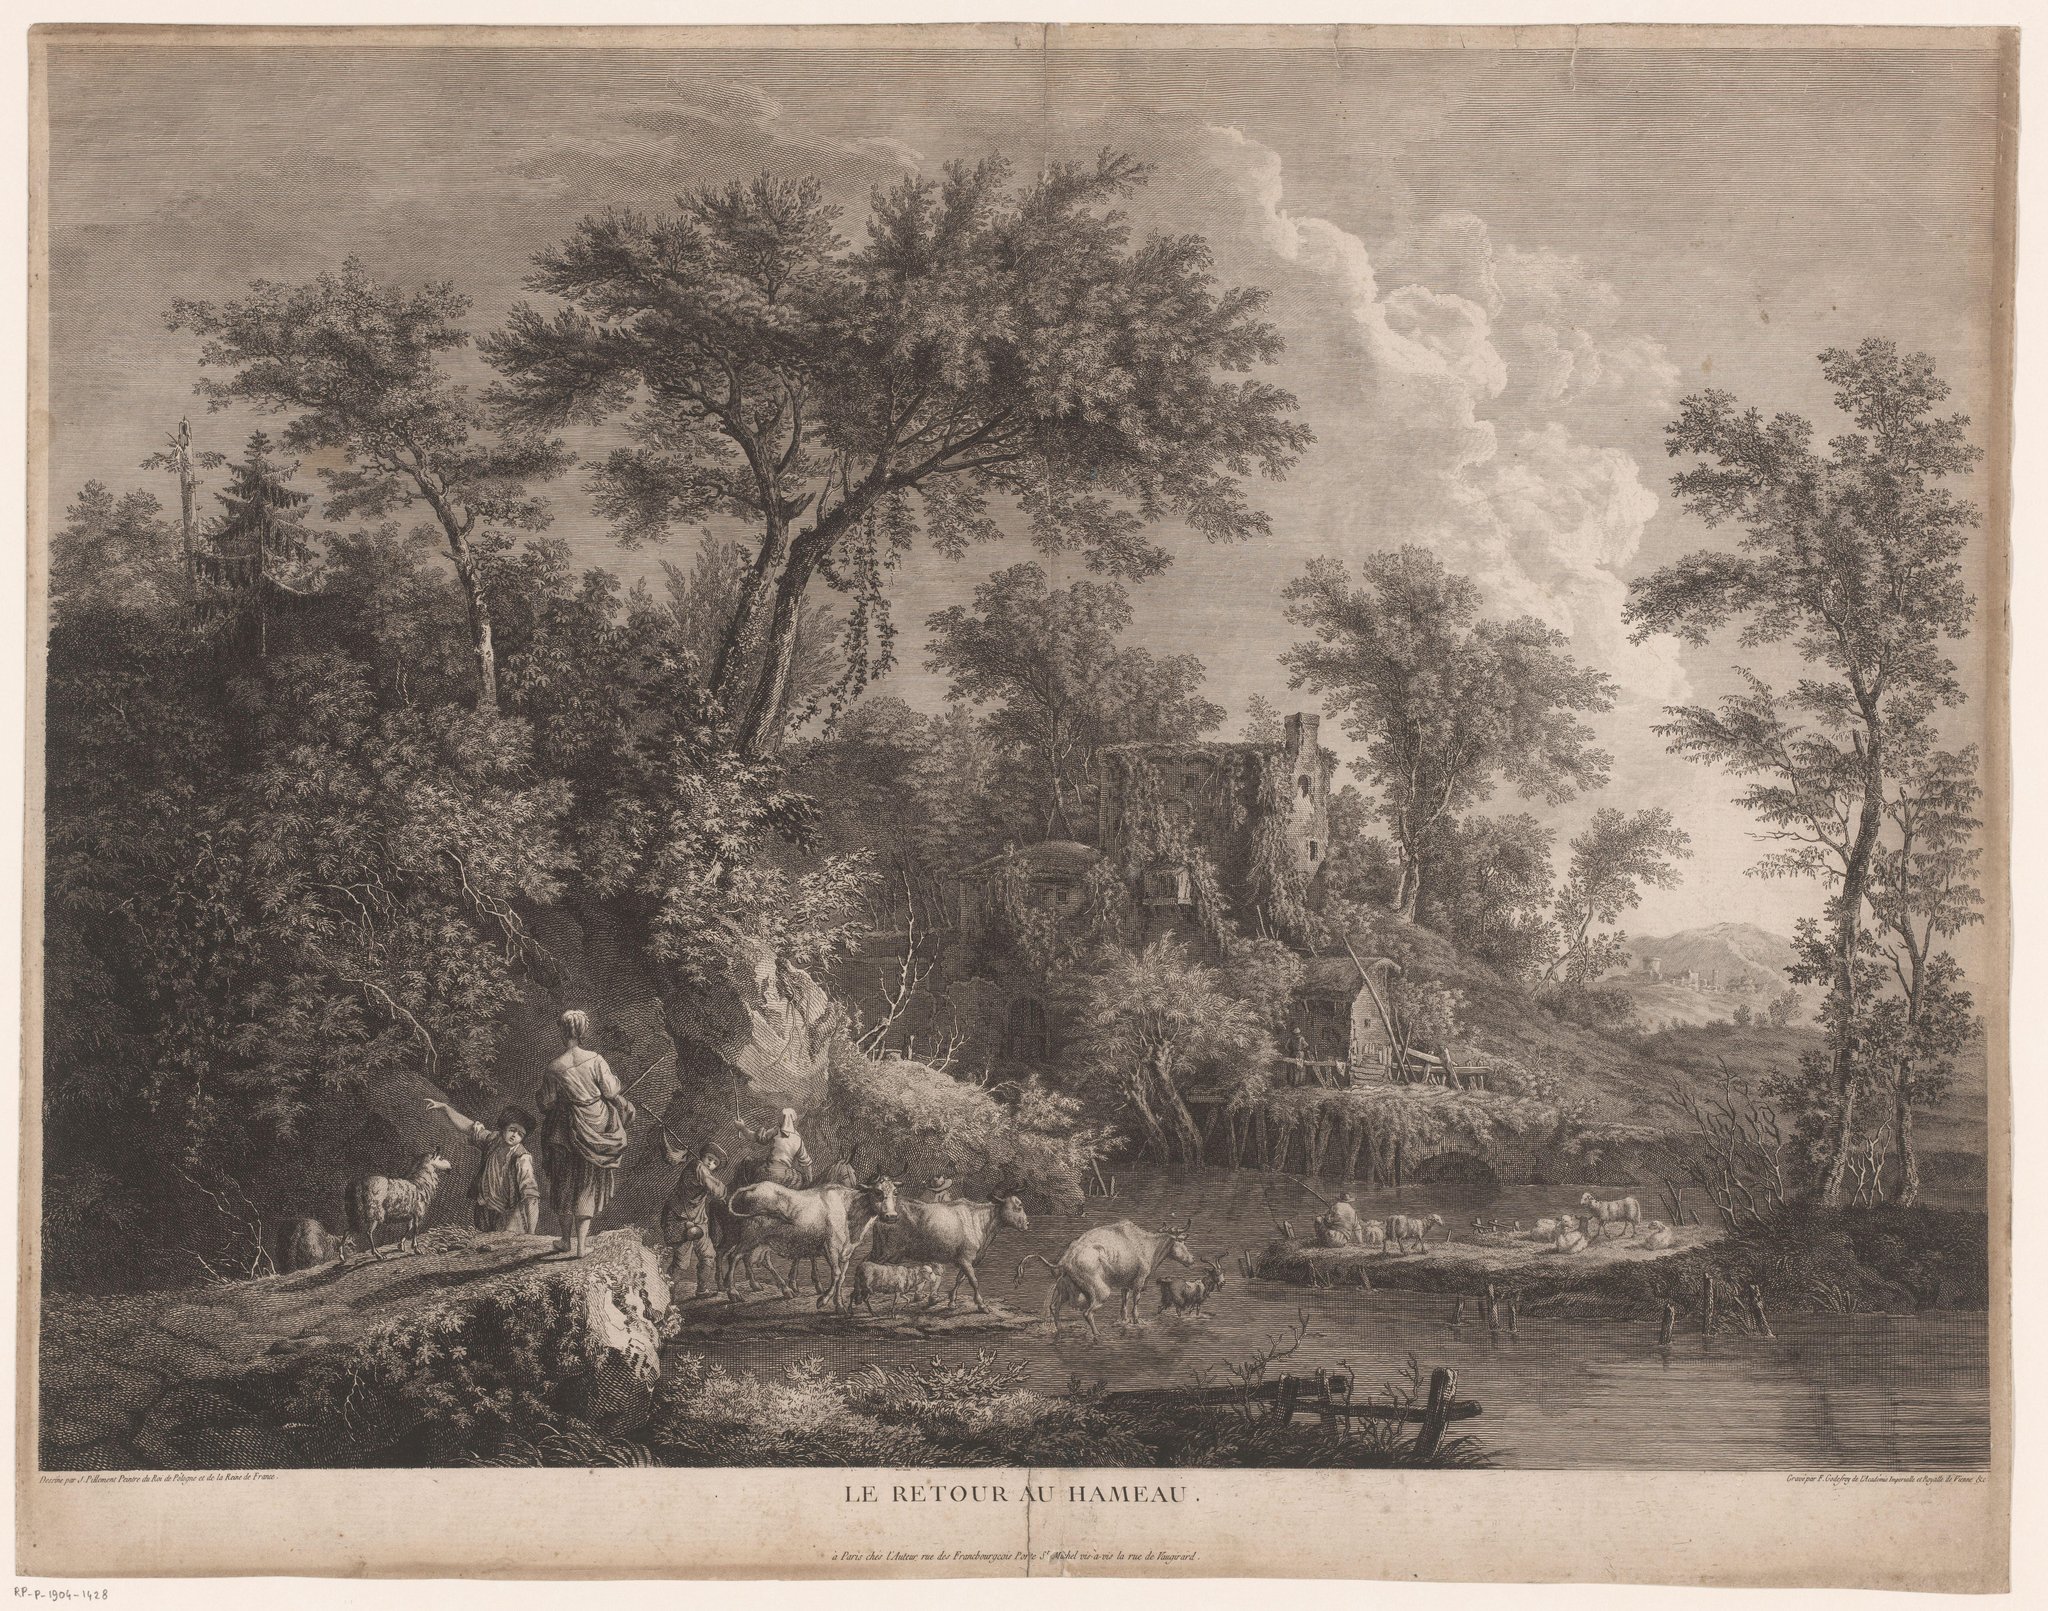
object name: print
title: Herders bij een doorwaadbare plaats met een vervallen gebouw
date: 1777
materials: paper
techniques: engraving, etching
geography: paris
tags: herding, herdsman, herdswoman, shepherd, shepherdess, cowherd, etc., ford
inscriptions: collector's mark: Lugt 2228